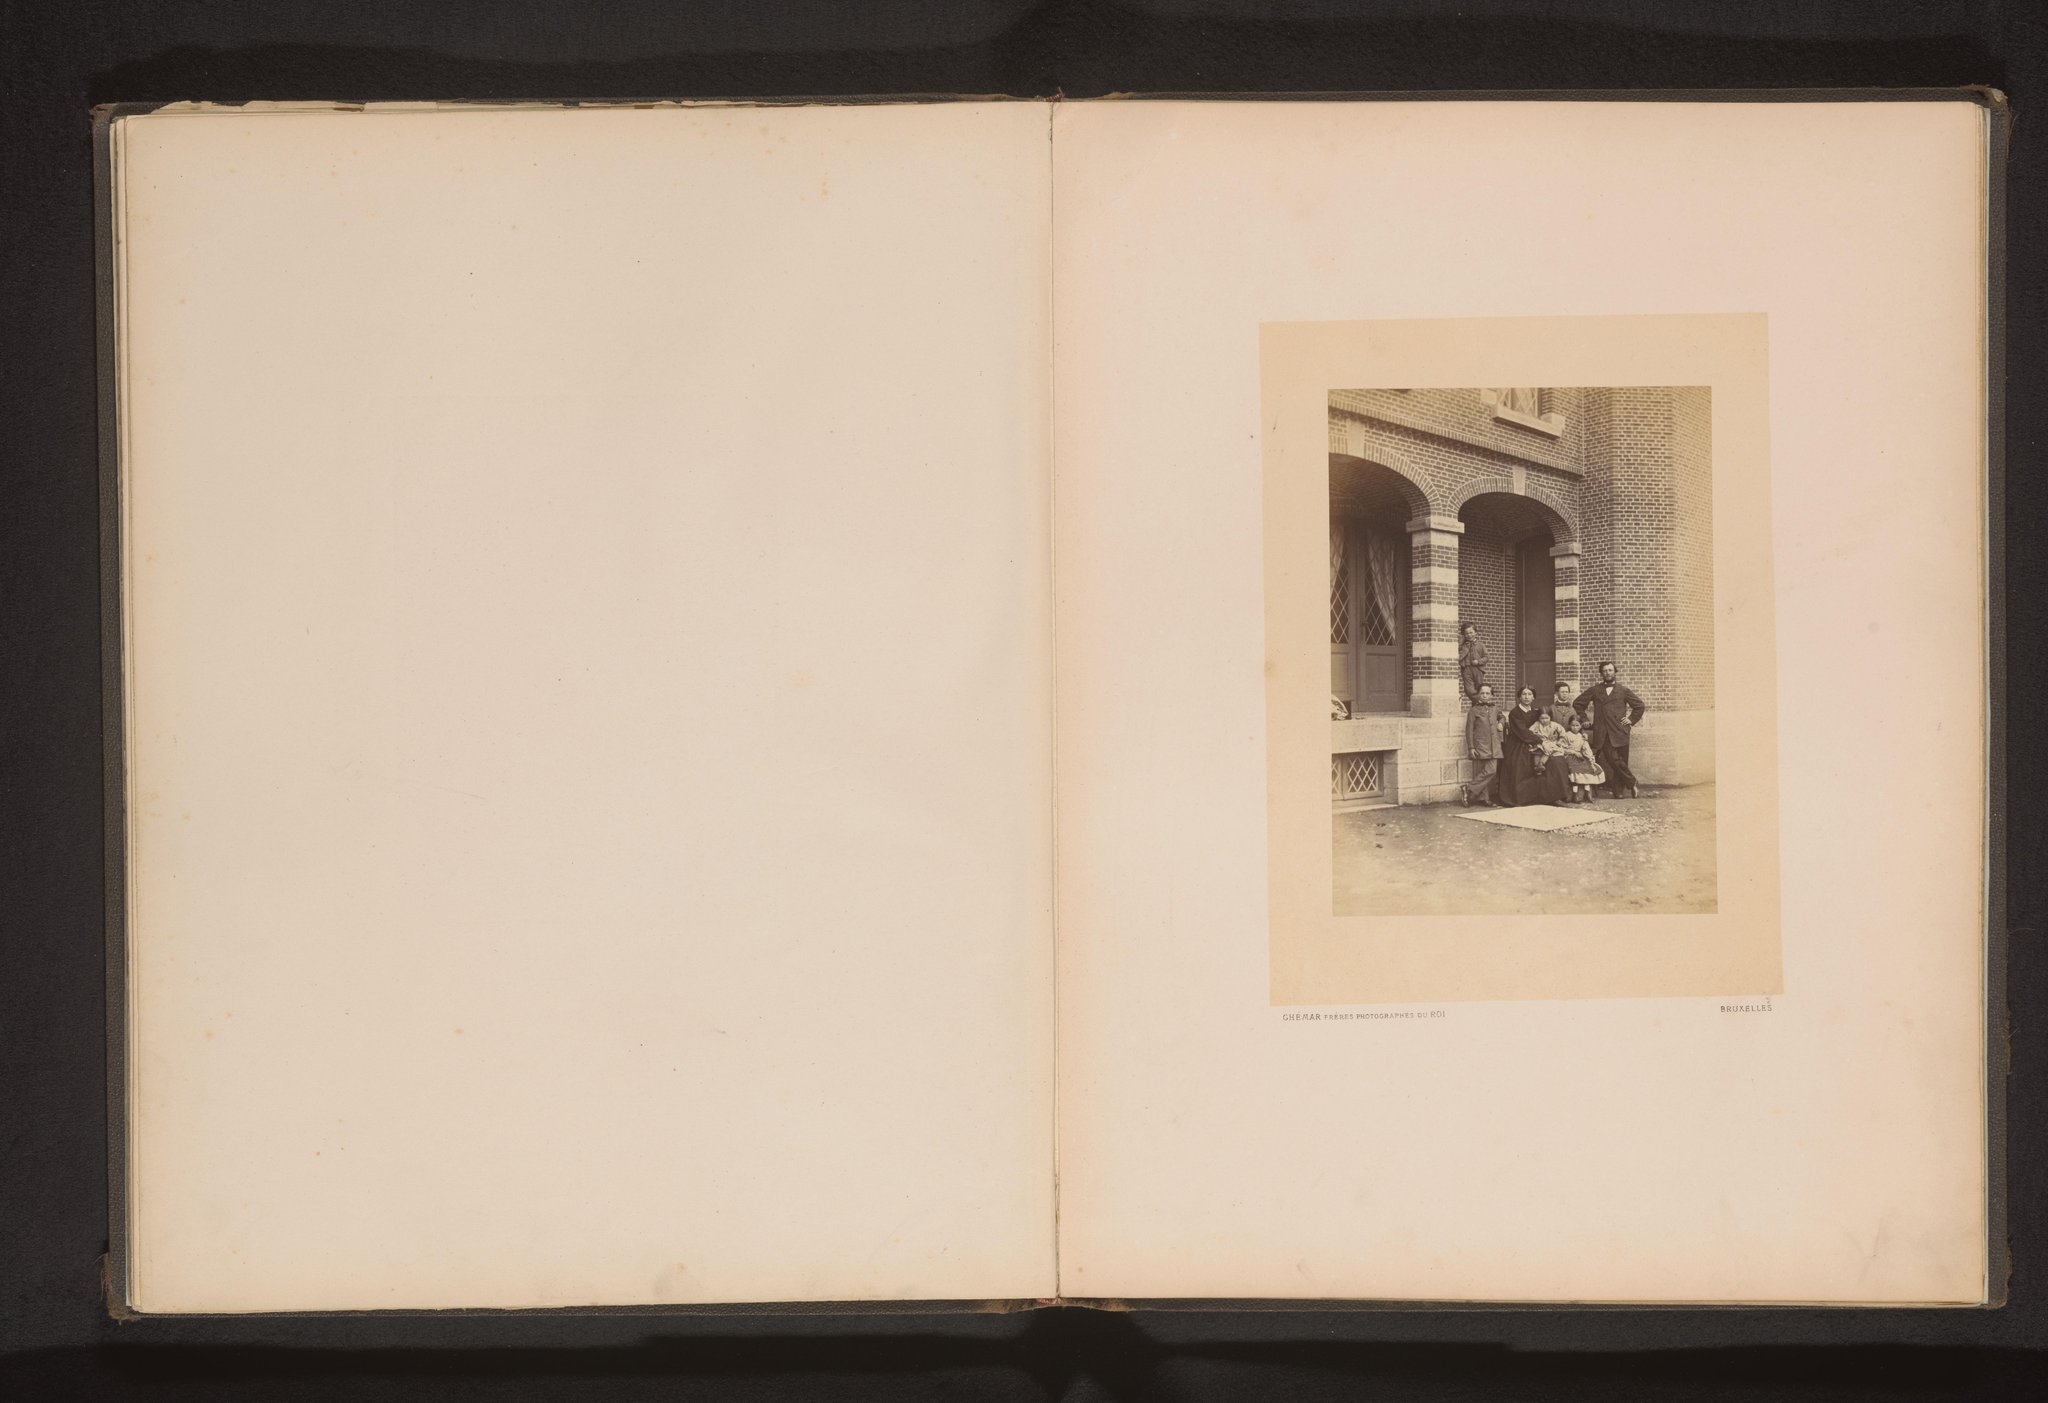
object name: photograph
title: Groepsportret van een onbekend gezelschap nabij Château de Marlagne te Wépion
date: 1862-1867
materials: photographic support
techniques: albumen print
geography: wépion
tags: castle, anonymous historical persons portrayed in a group, in a group-portrait